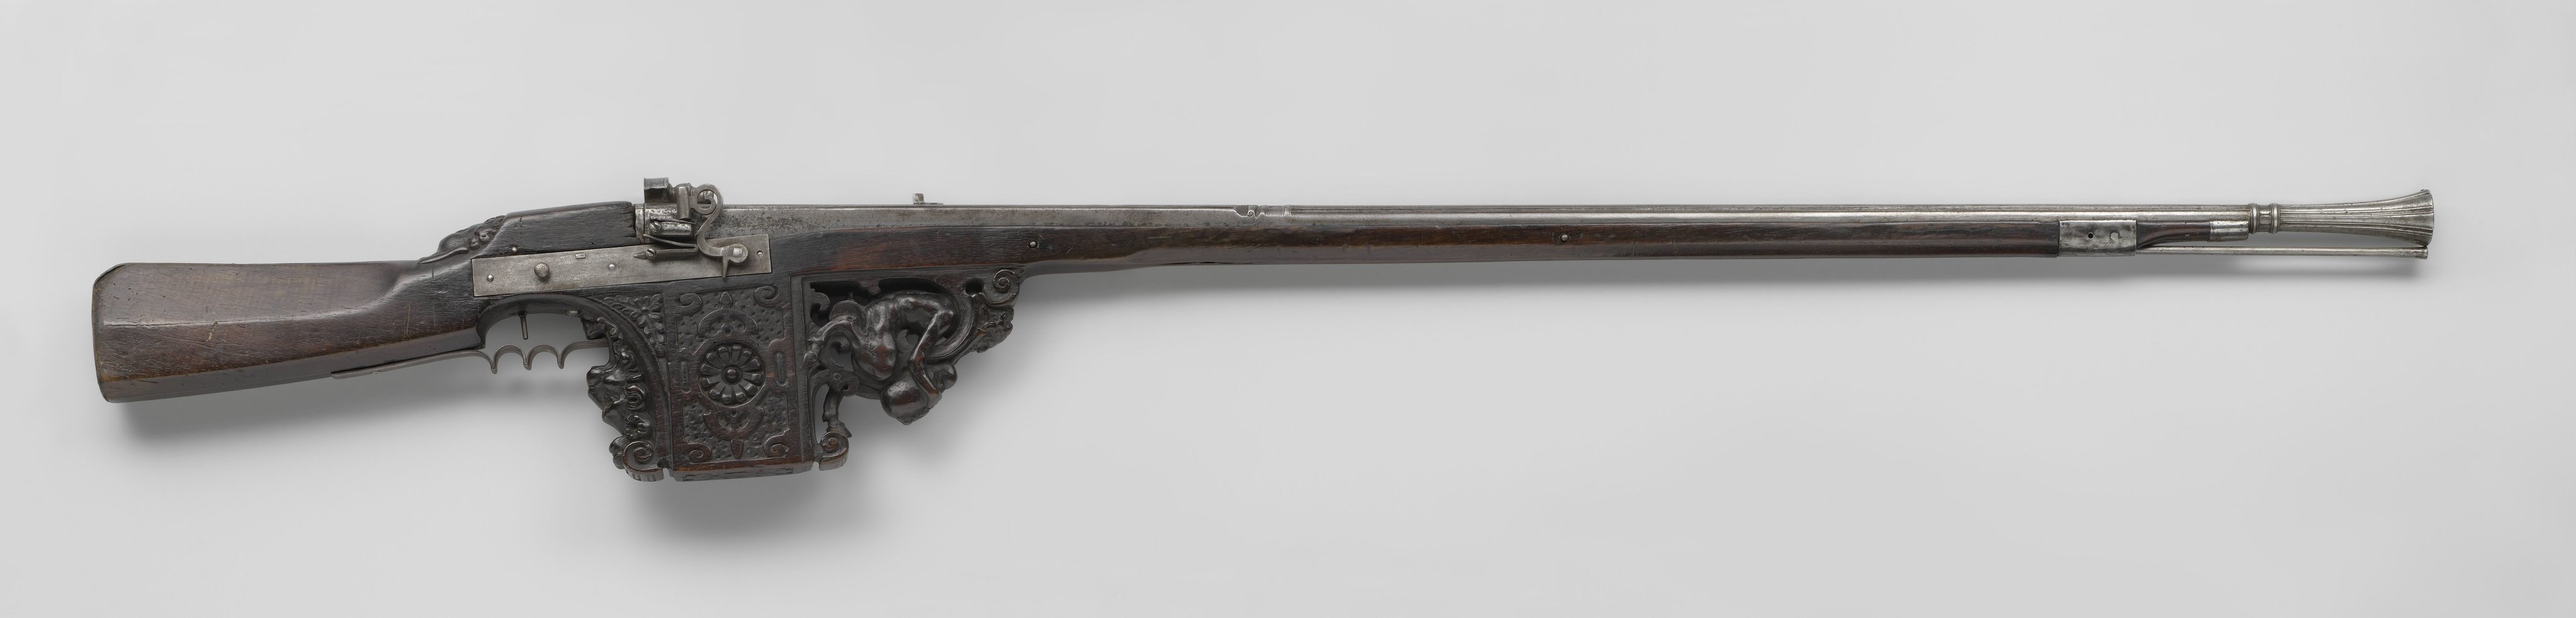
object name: target rifle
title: Doelgeweer met tondelsnapslot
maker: Anonymous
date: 1620-1629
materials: iron, steel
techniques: printing, cutting, embroidery, soldering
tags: rosette ~ ornament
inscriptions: mark, number: ‘162[..]’